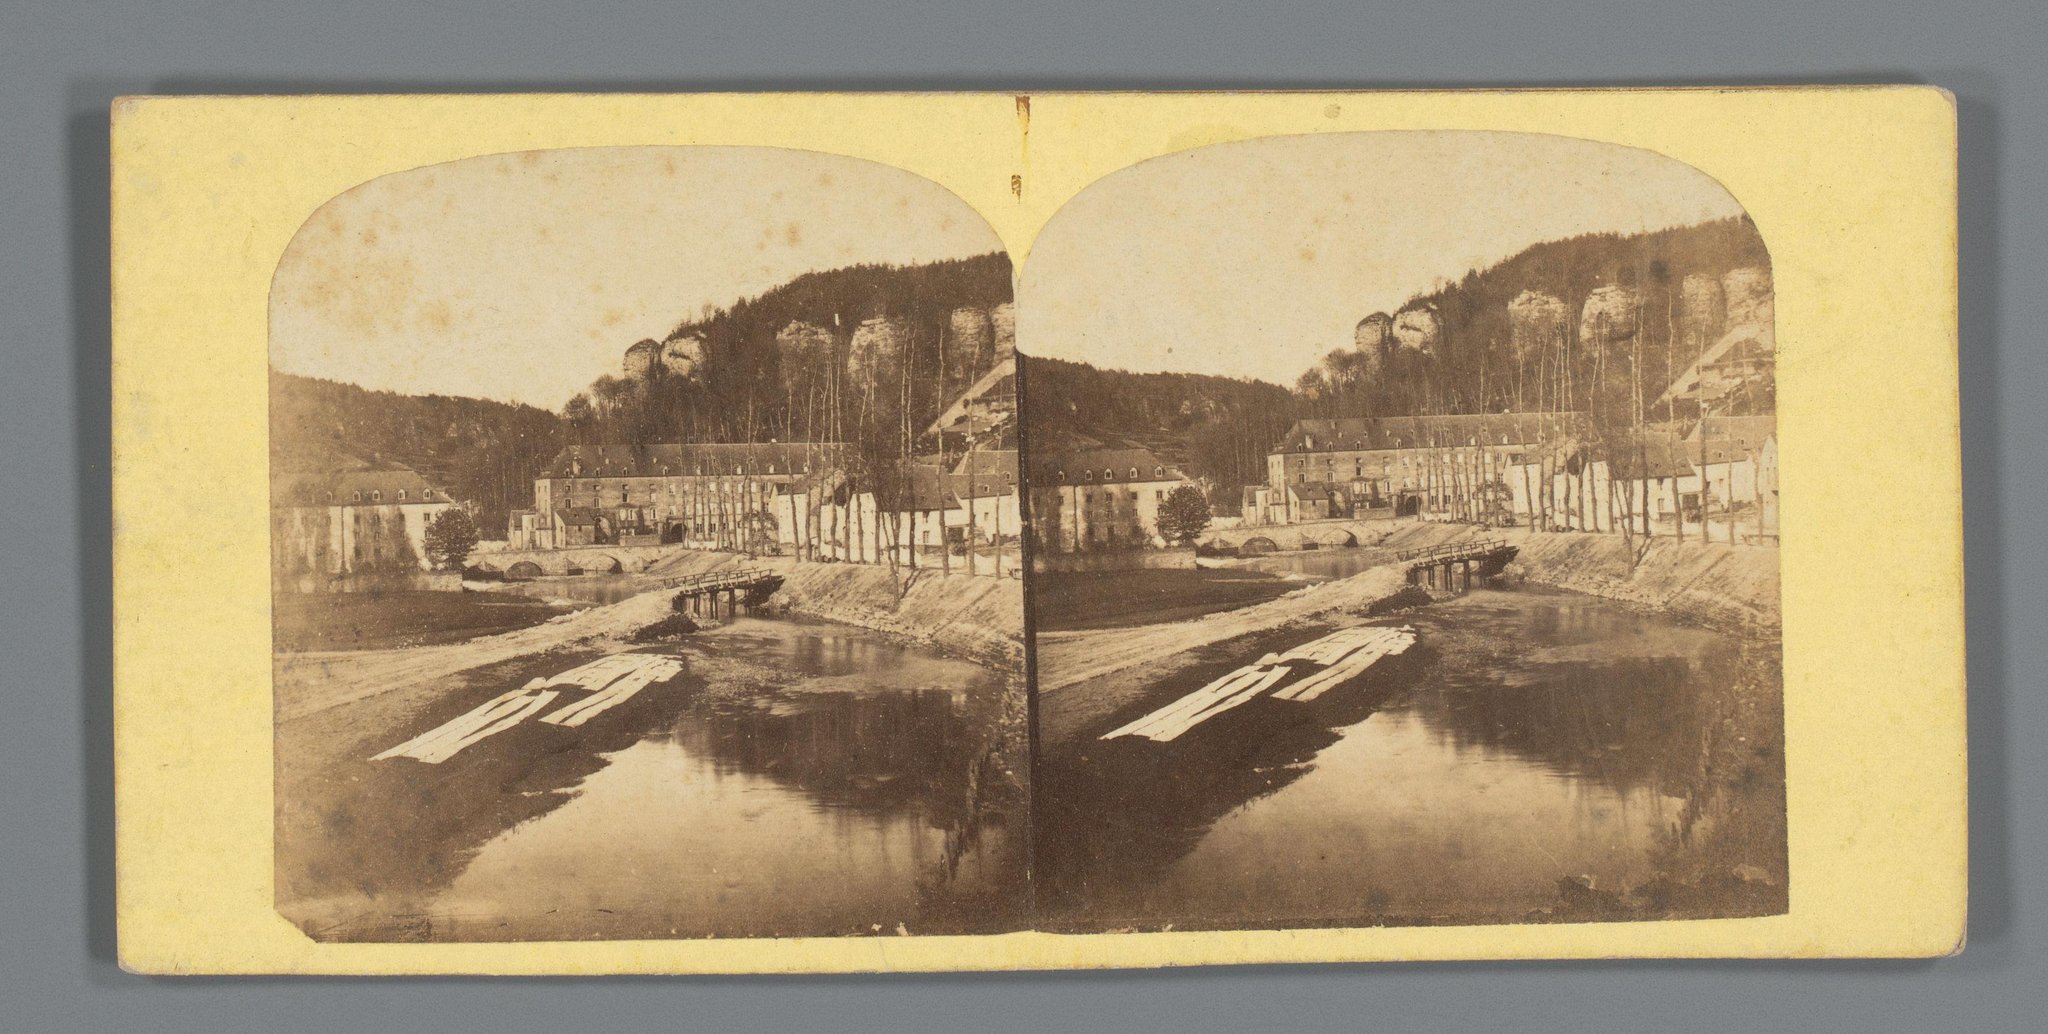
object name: stereograph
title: Fond de Clausen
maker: Anonymous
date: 1861-1870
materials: cardboard, paper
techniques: albumen print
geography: luxembourg city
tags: city-view, and landscape with man-made constructions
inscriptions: collector's mark: ‘Librairie de E. HOFFMAN à Luxembourg.’, inscription: ‘7’, number: ‘No. 7.’